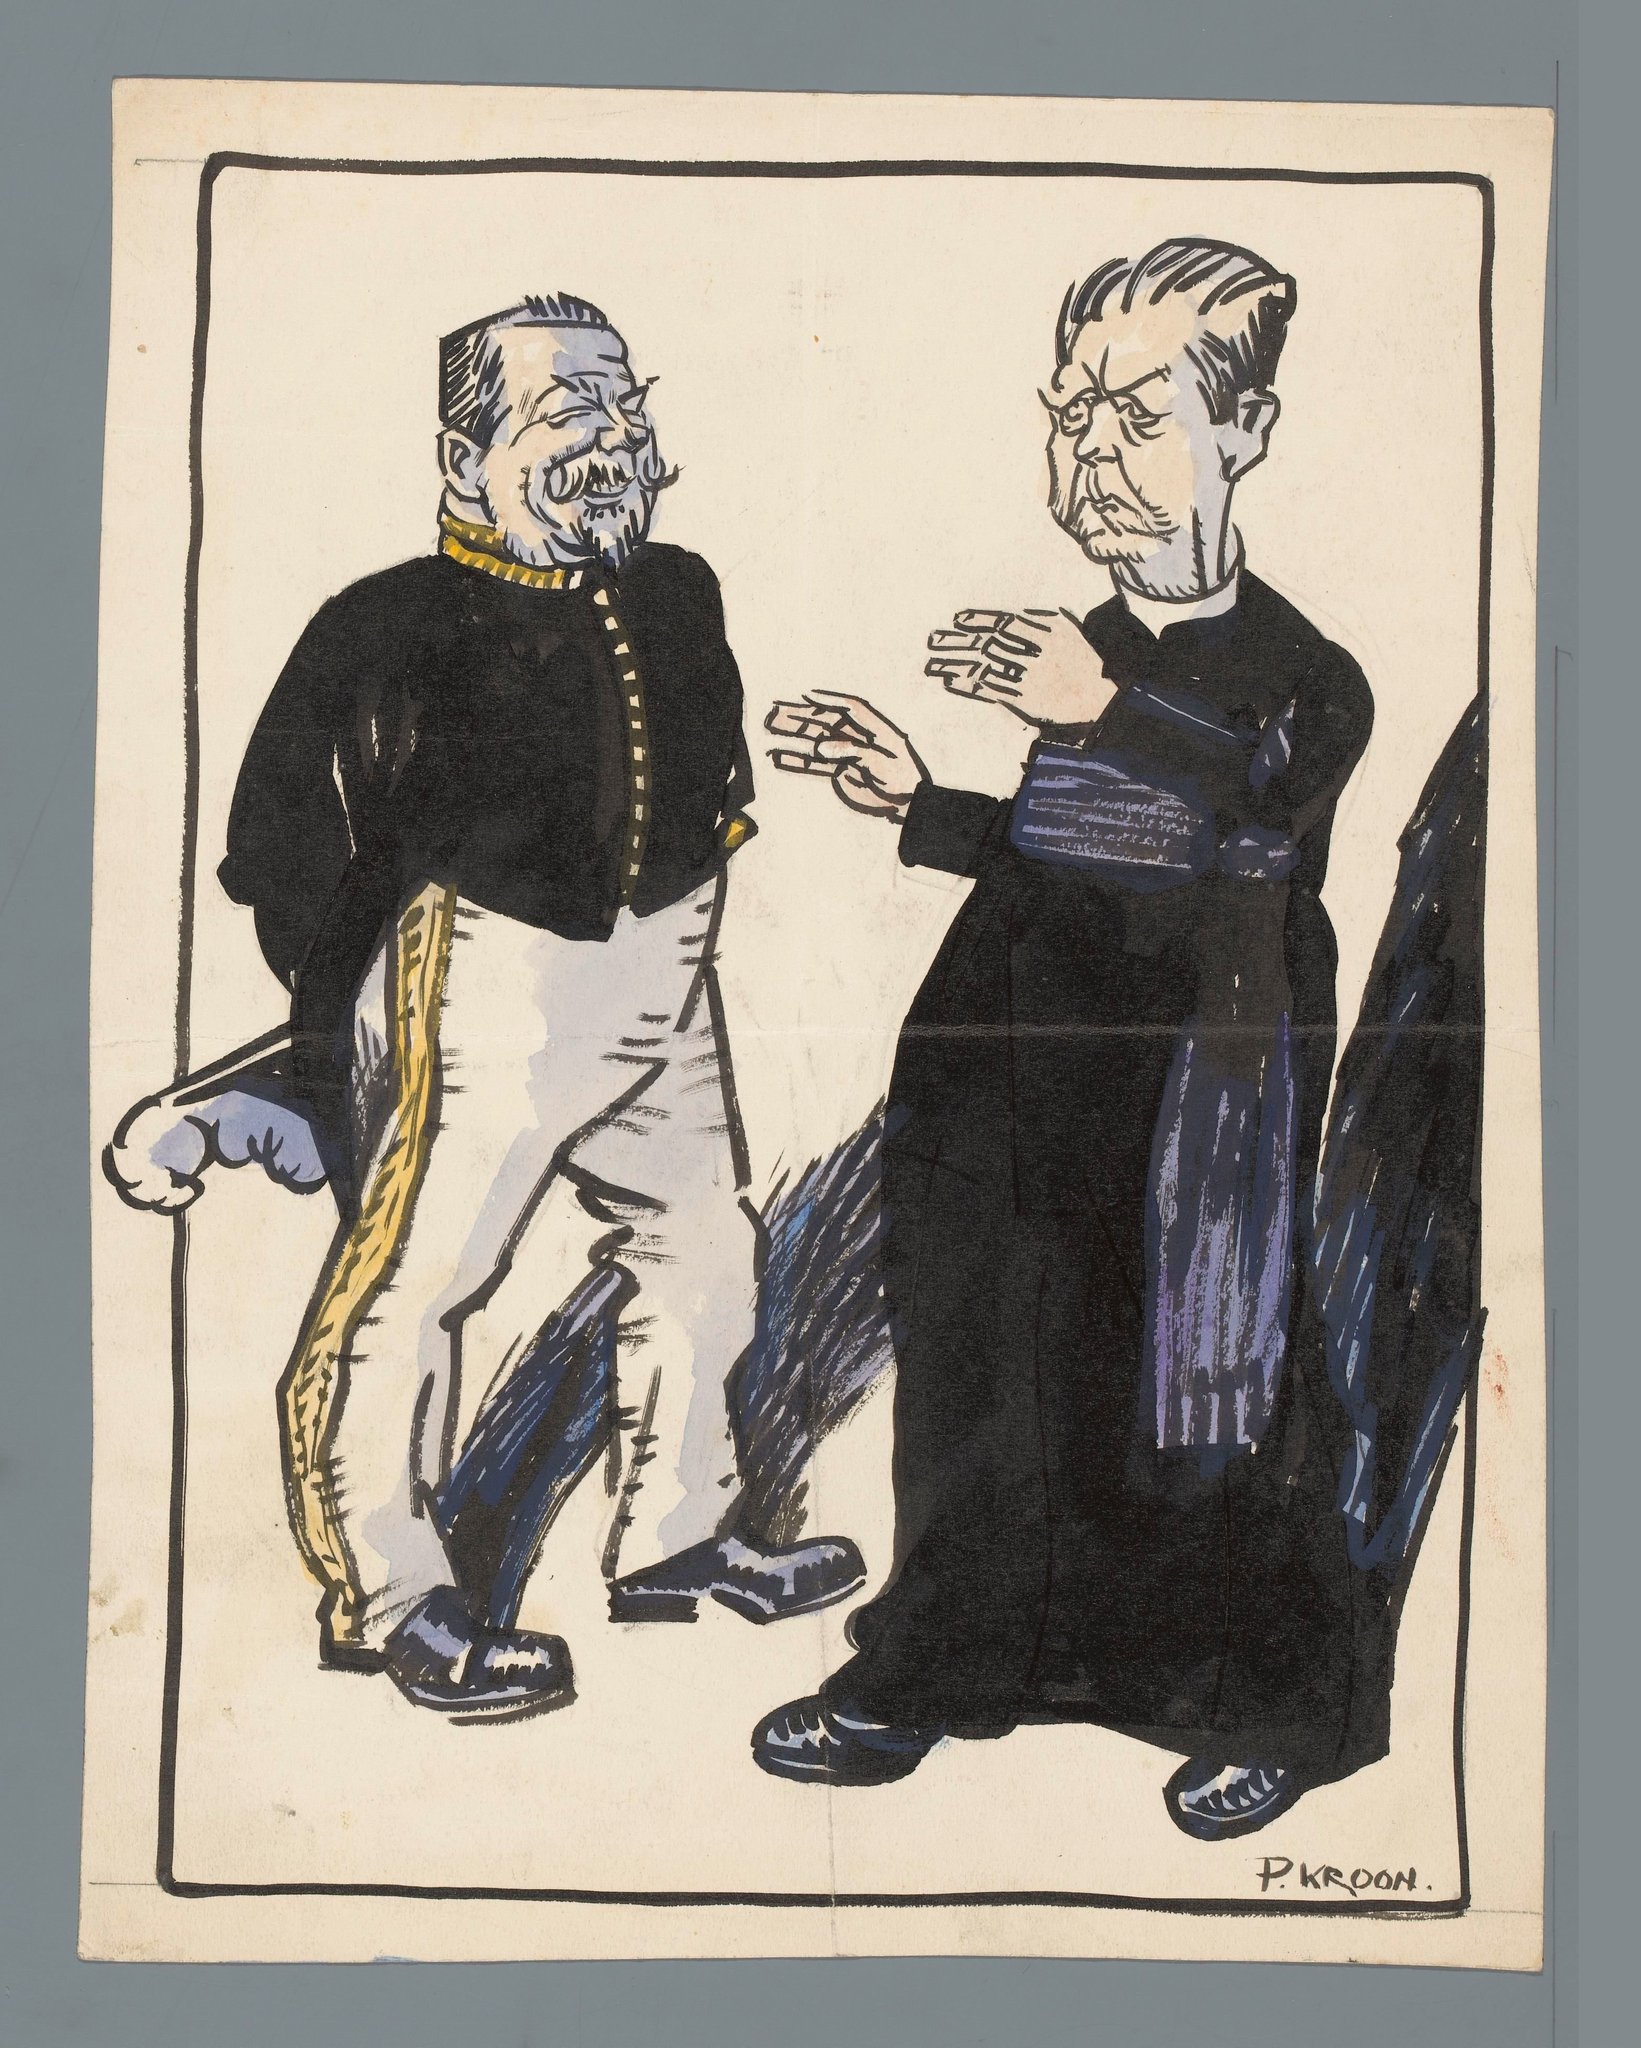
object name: cartoon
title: Minister en een priester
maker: patricq kroon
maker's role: draughtsman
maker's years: 1862-1941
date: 1920-1930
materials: ink, paper, pencil, watercolor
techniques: brush, pen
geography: netherlands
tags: minister ~ government, priest (roman catholic), political caricatures and satires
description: Een lachende minister en een sombere priester. Schets voor een politieke spotprent.